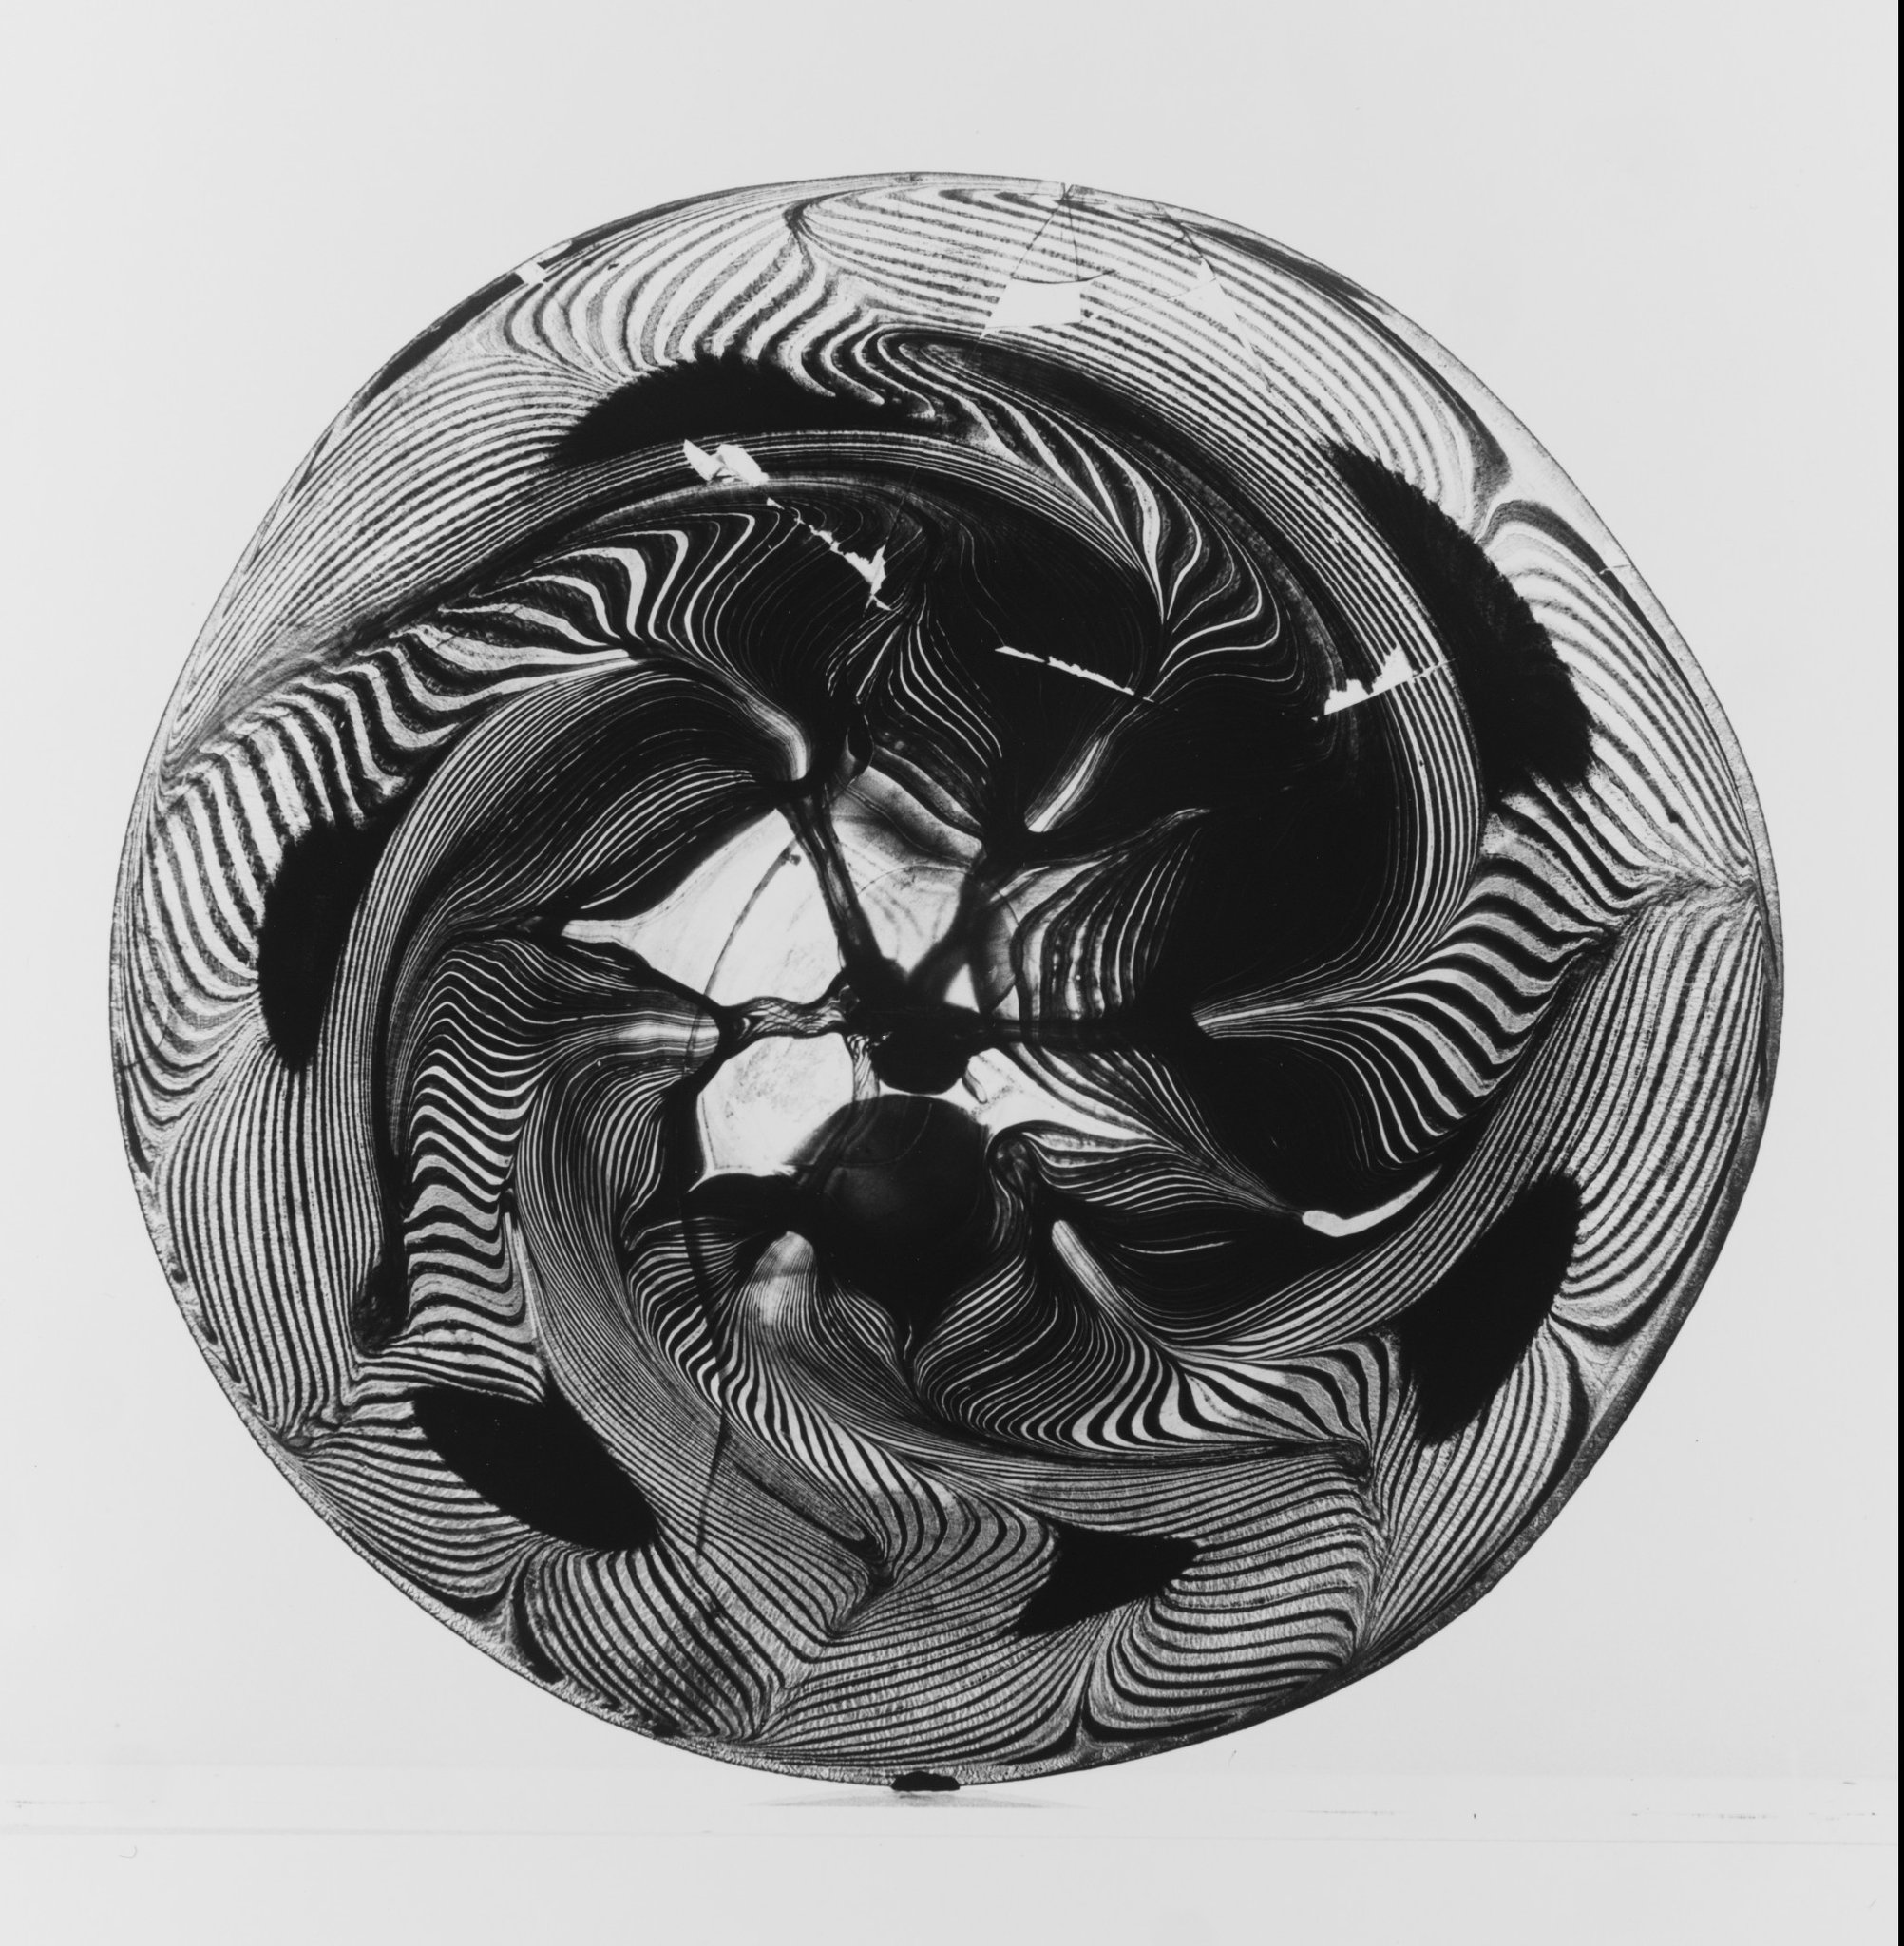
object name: plaque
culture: american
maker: louis c. tiffany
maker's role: designer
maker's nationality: american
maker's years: 1848-1933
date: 1893-1896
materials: glass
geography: united states